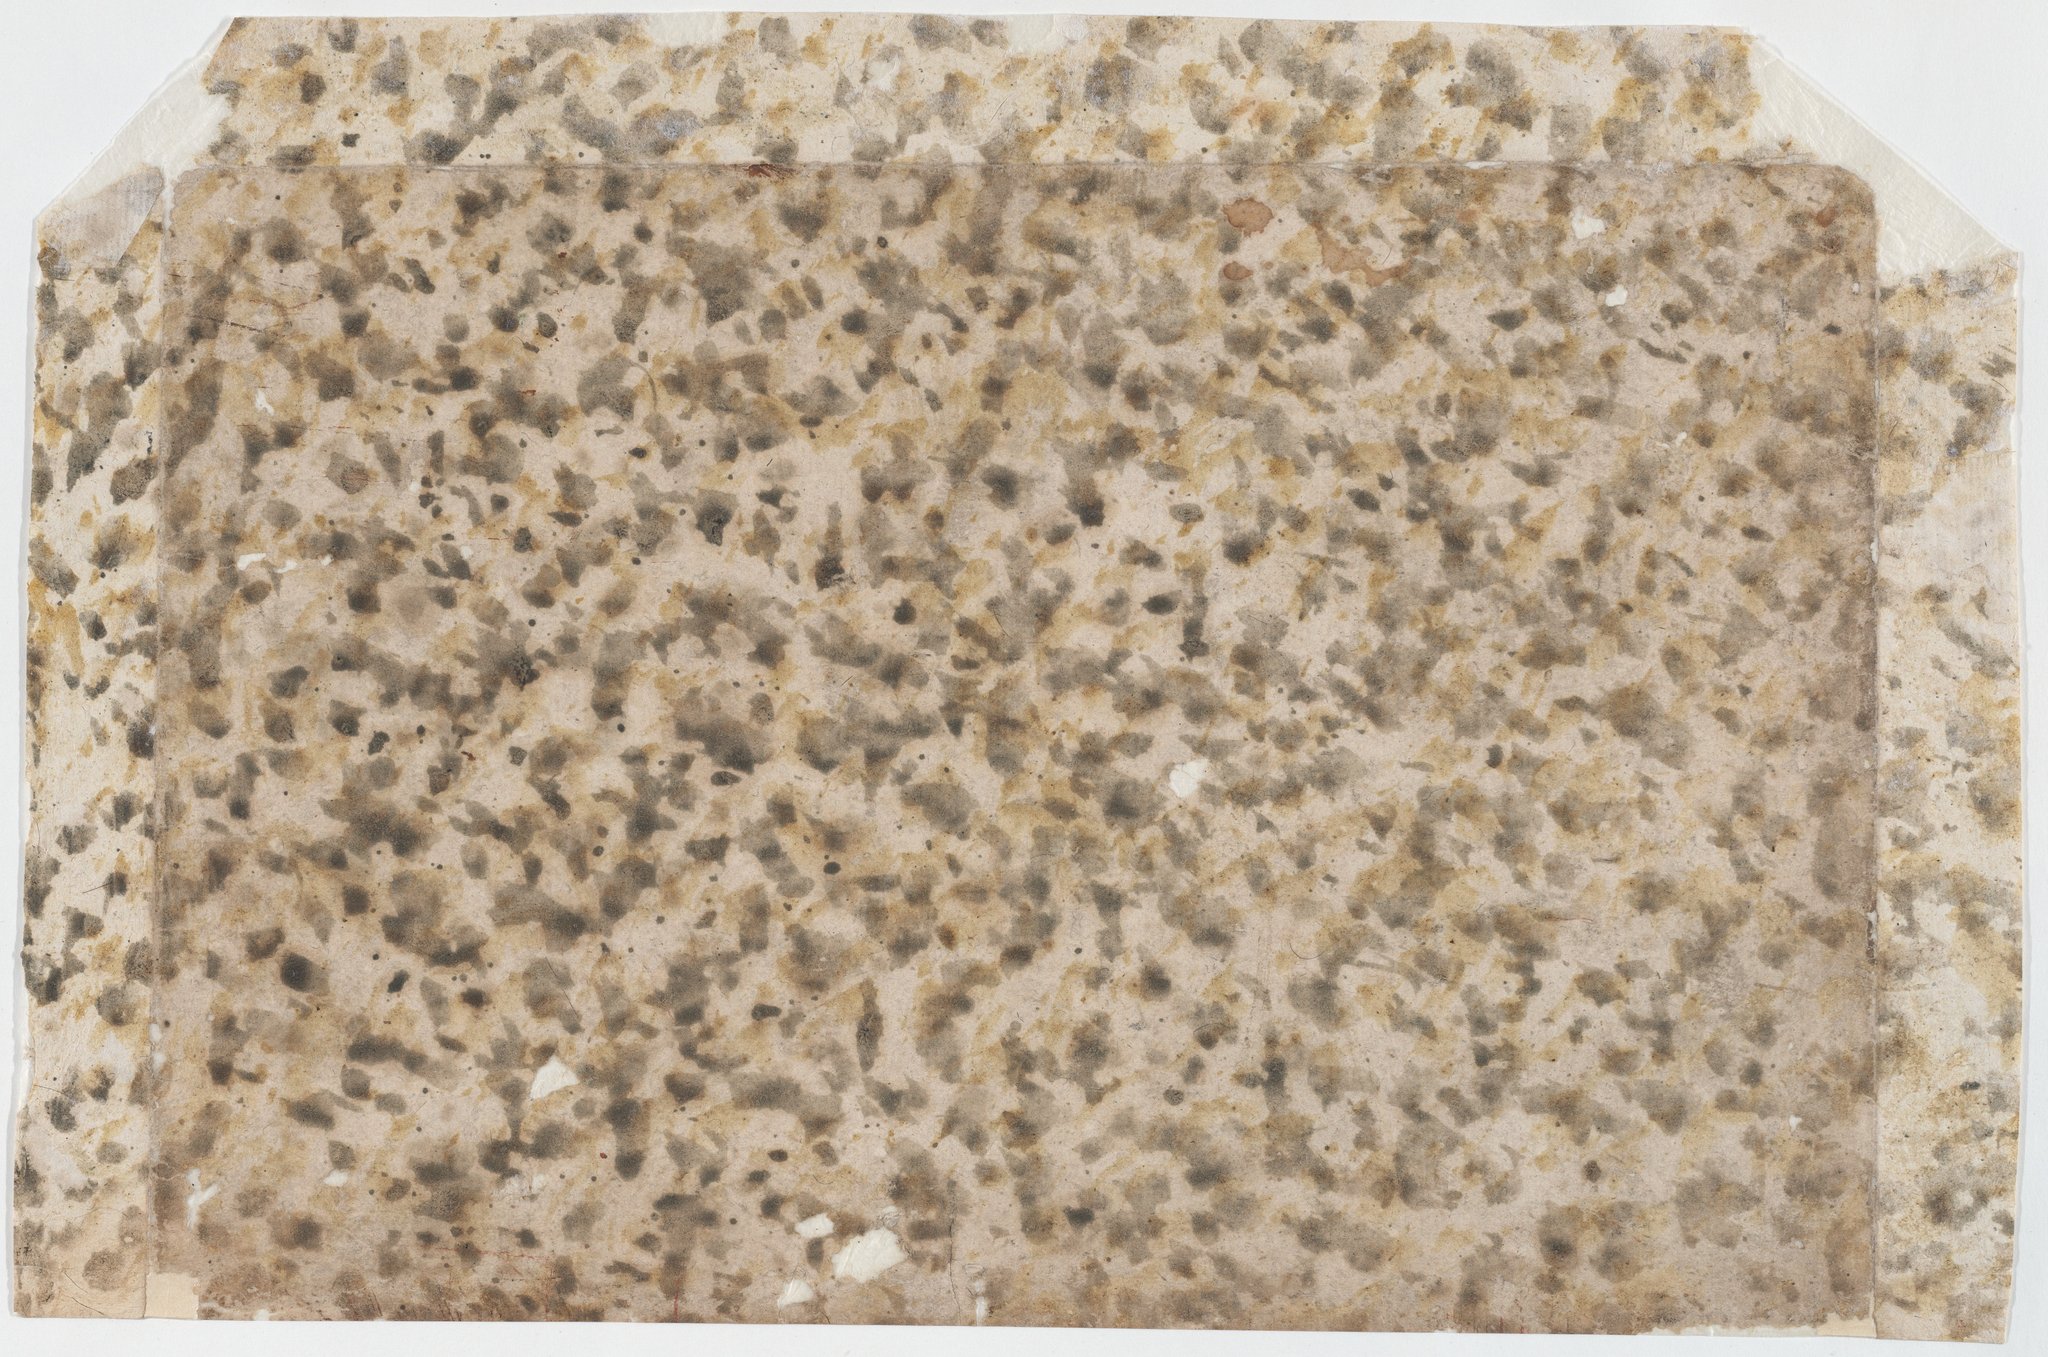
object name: print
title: Sheet with overall spotted design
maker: Anonymous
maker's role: artist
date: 1801-1900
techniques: relief print